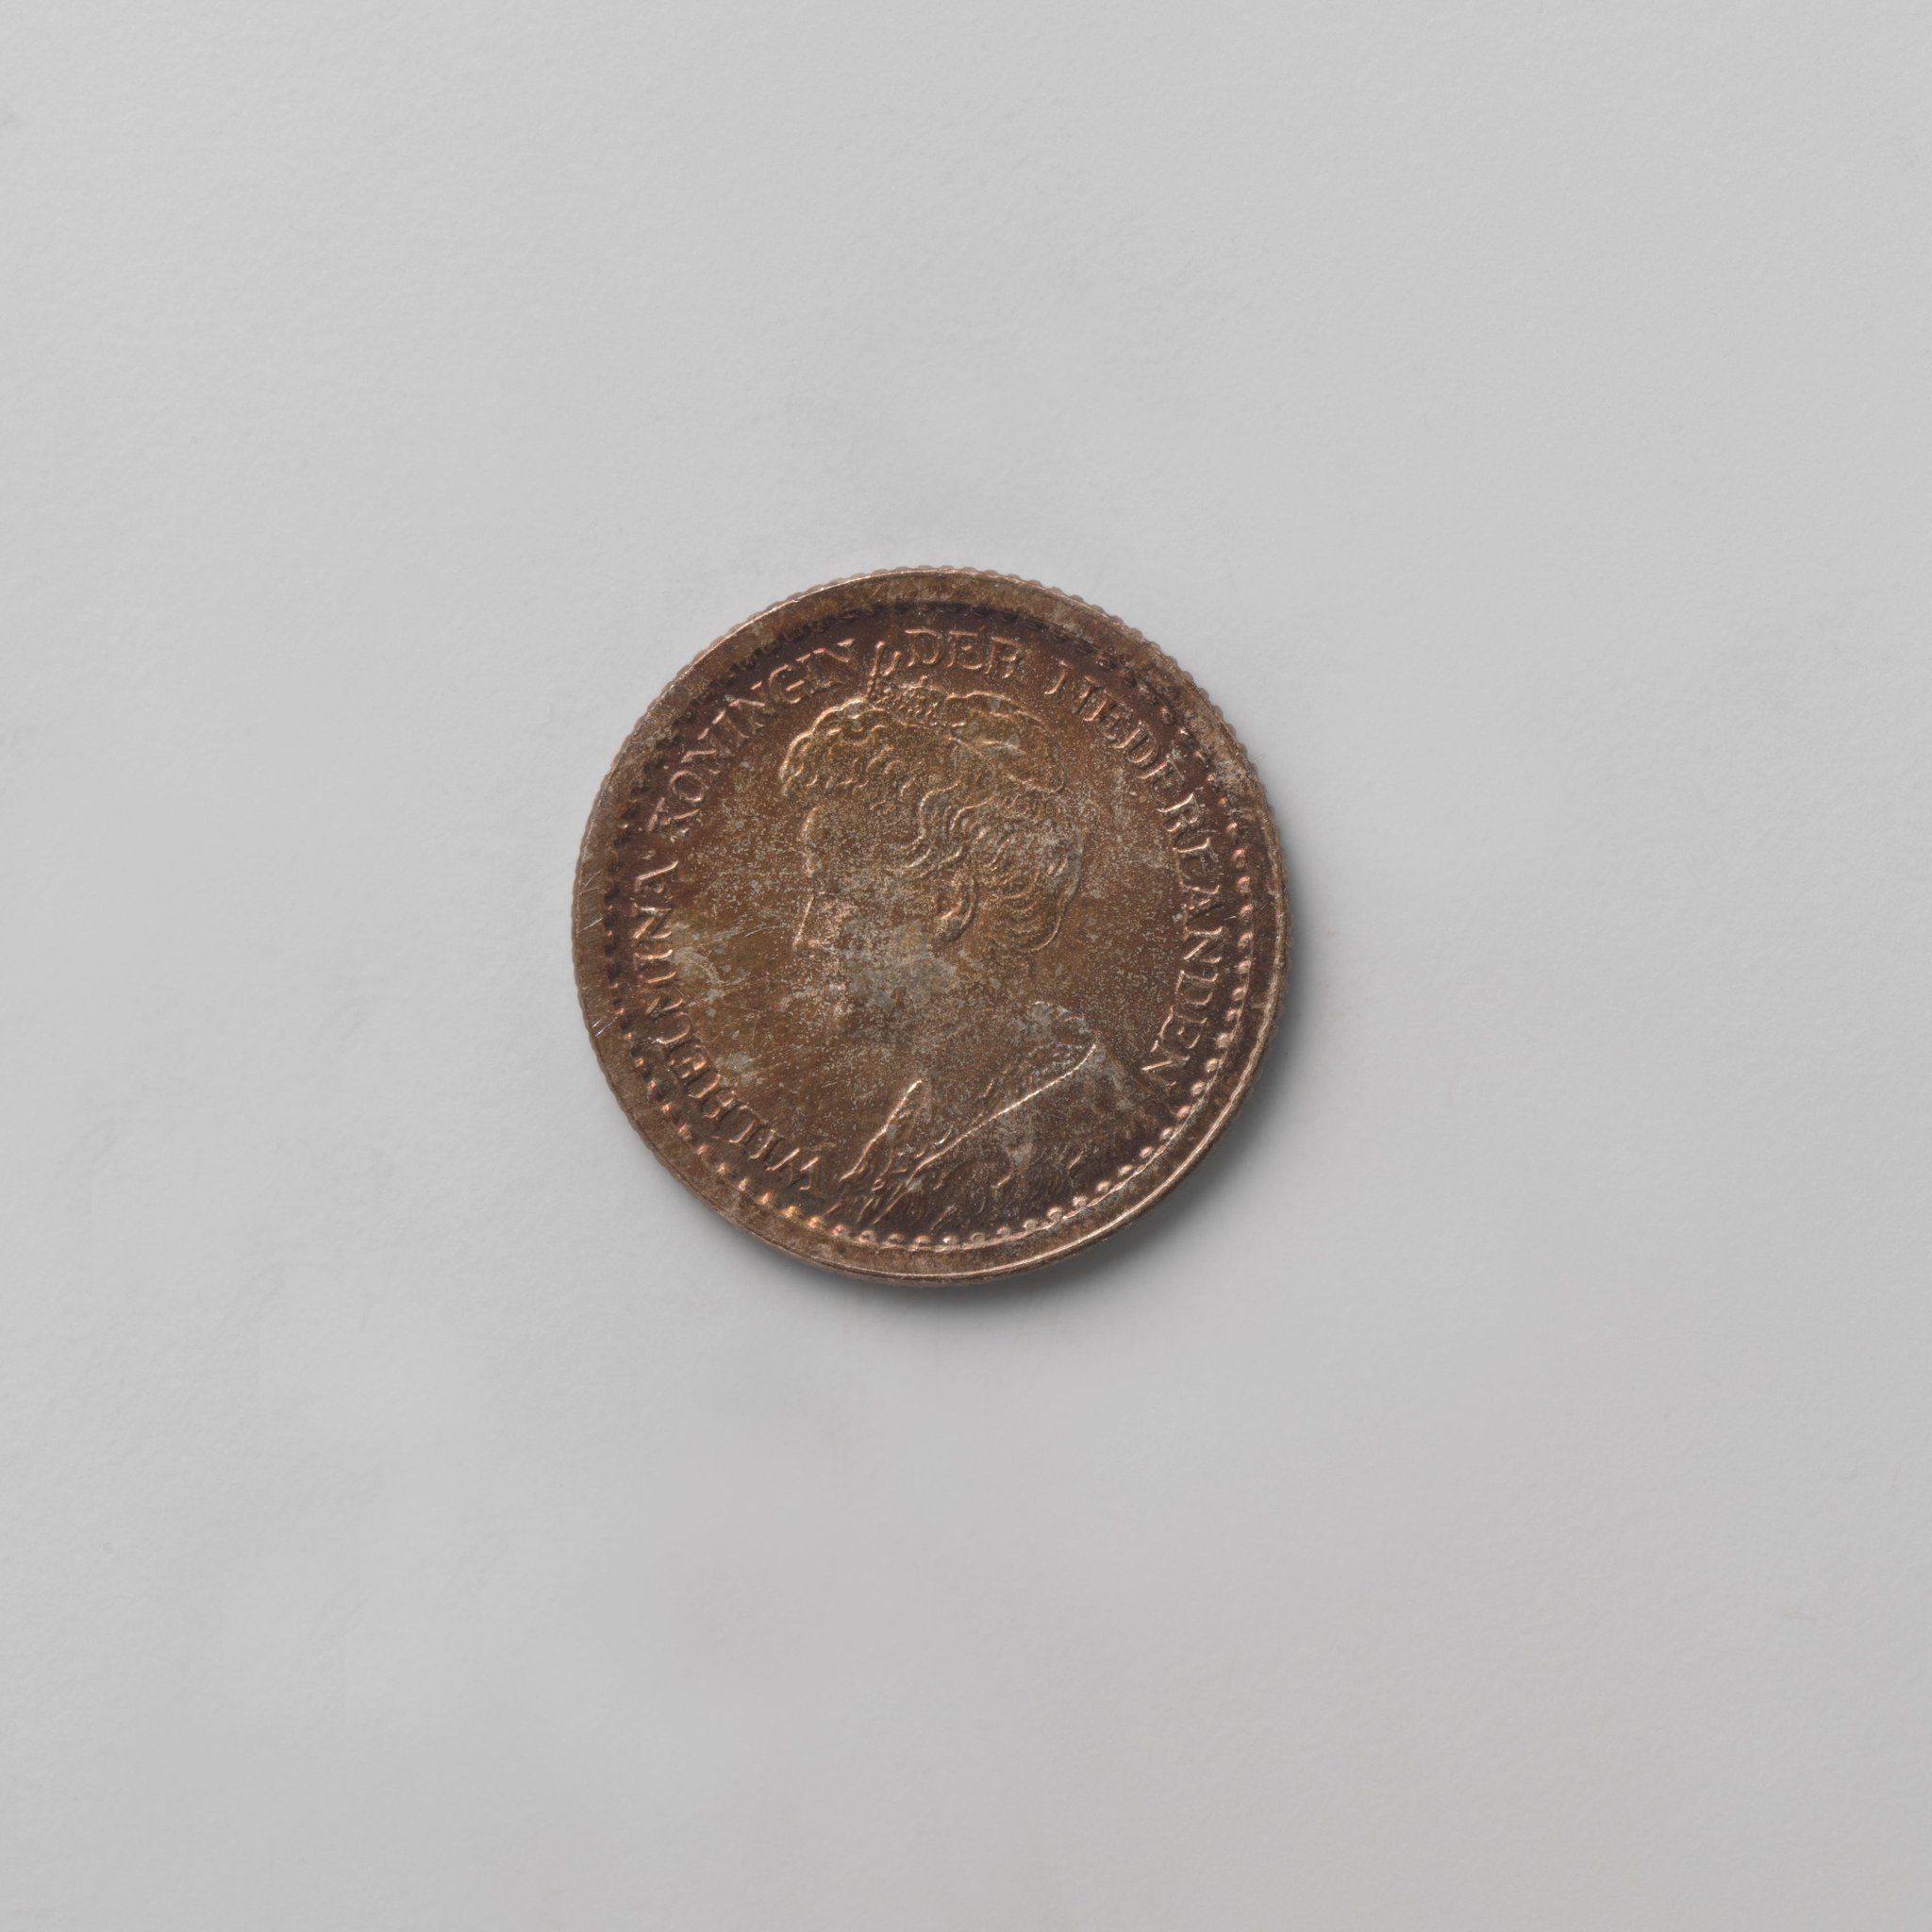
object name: coin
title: Nederland,10 cent,1917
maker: wilhelmina of the netherlands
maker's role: print maker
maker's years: 1880-1962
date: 1917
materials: silver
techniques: striking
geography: utrecht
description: Zilveren munt. Voorzijde: gedrapeerd borstbeeld naar links. Keerzijde: binnen twee samengebonden eiketakken waarde-aanduiding 10 cents en jaartal. Kartelrand.